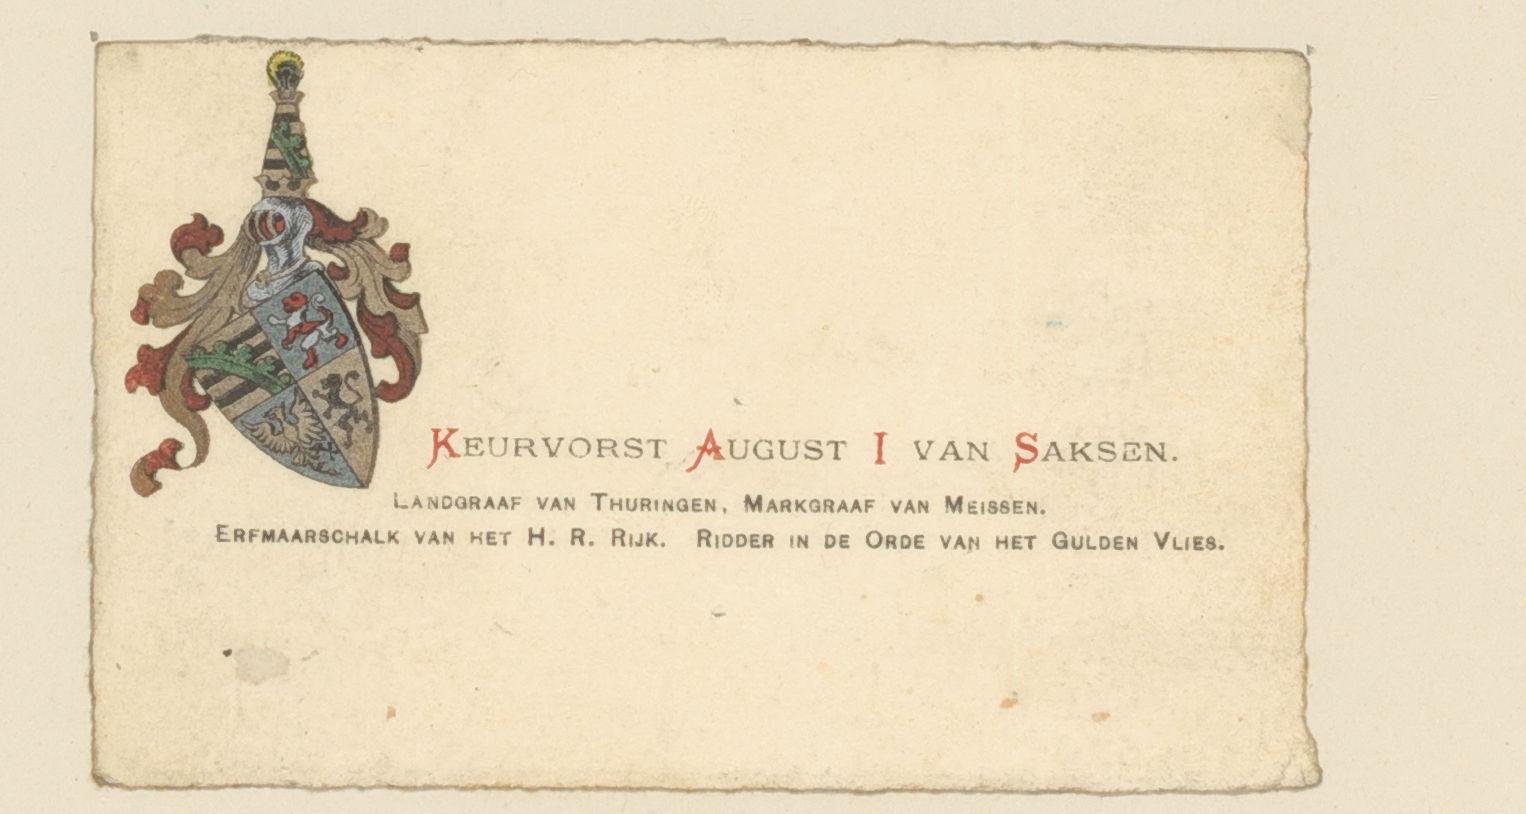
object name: visiting card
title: Visitekaartje van August van Saksen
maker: Anonymous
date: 1896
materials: paper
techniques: chromolithography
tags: armorial bearing, heraldry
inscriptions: stamp, collector's mark: Lugt 1641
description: Visitekaartje van August van Saksen. Gemaakt ter gelegenheid van de Ridderhofspelen gehouden tussen 24 en 26 juni 1896 in Utrecht ter gelegenheid van het 52e lustrum van de Universiteit. Het thema van de Ridderhofspelen is het Ridderhofspel te Wenen in 1560. Onderwerpsrubrieken binnen de Atlas Zeden en Gewoonten: Onderwijs en Wetenschappen, Studentenleven.